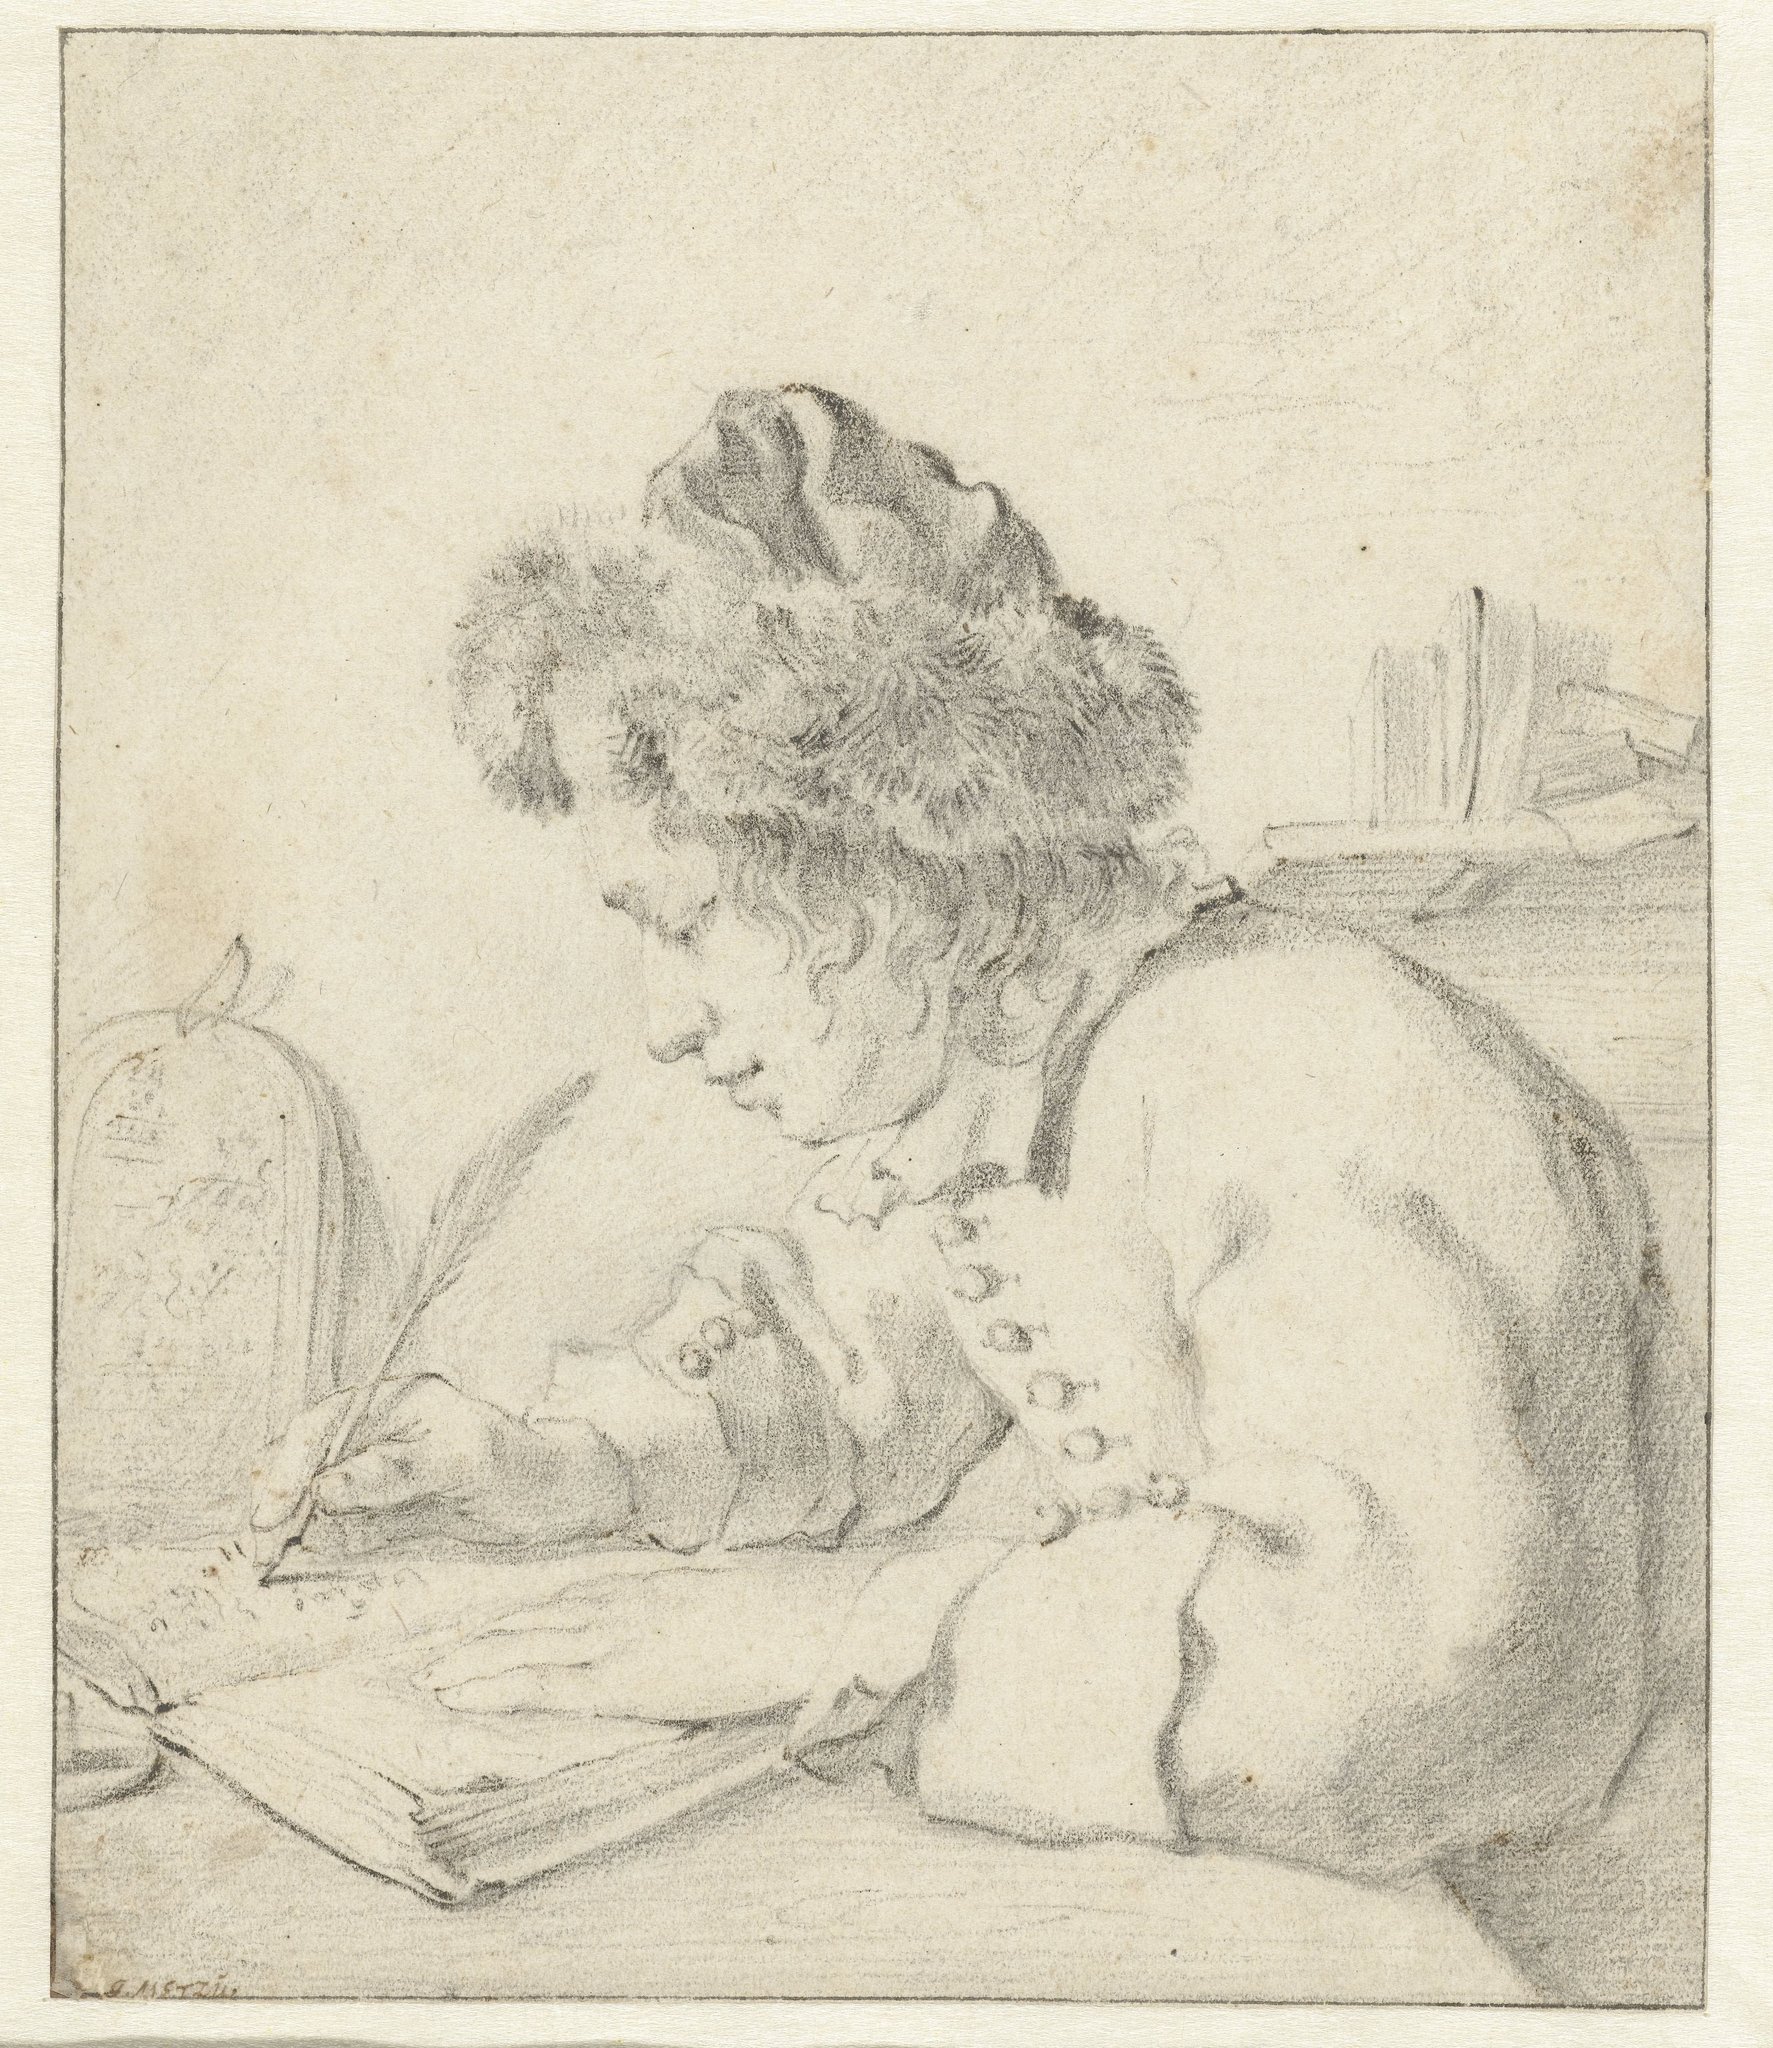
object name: drawing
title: Young Man with a Fur Cap, Seated and Writing in an Account Book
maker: constantijn verhout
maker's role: draughtsman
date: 1650-1660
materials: chalk, paper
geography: gouda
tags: handwriting, writing as activity, sitting figure